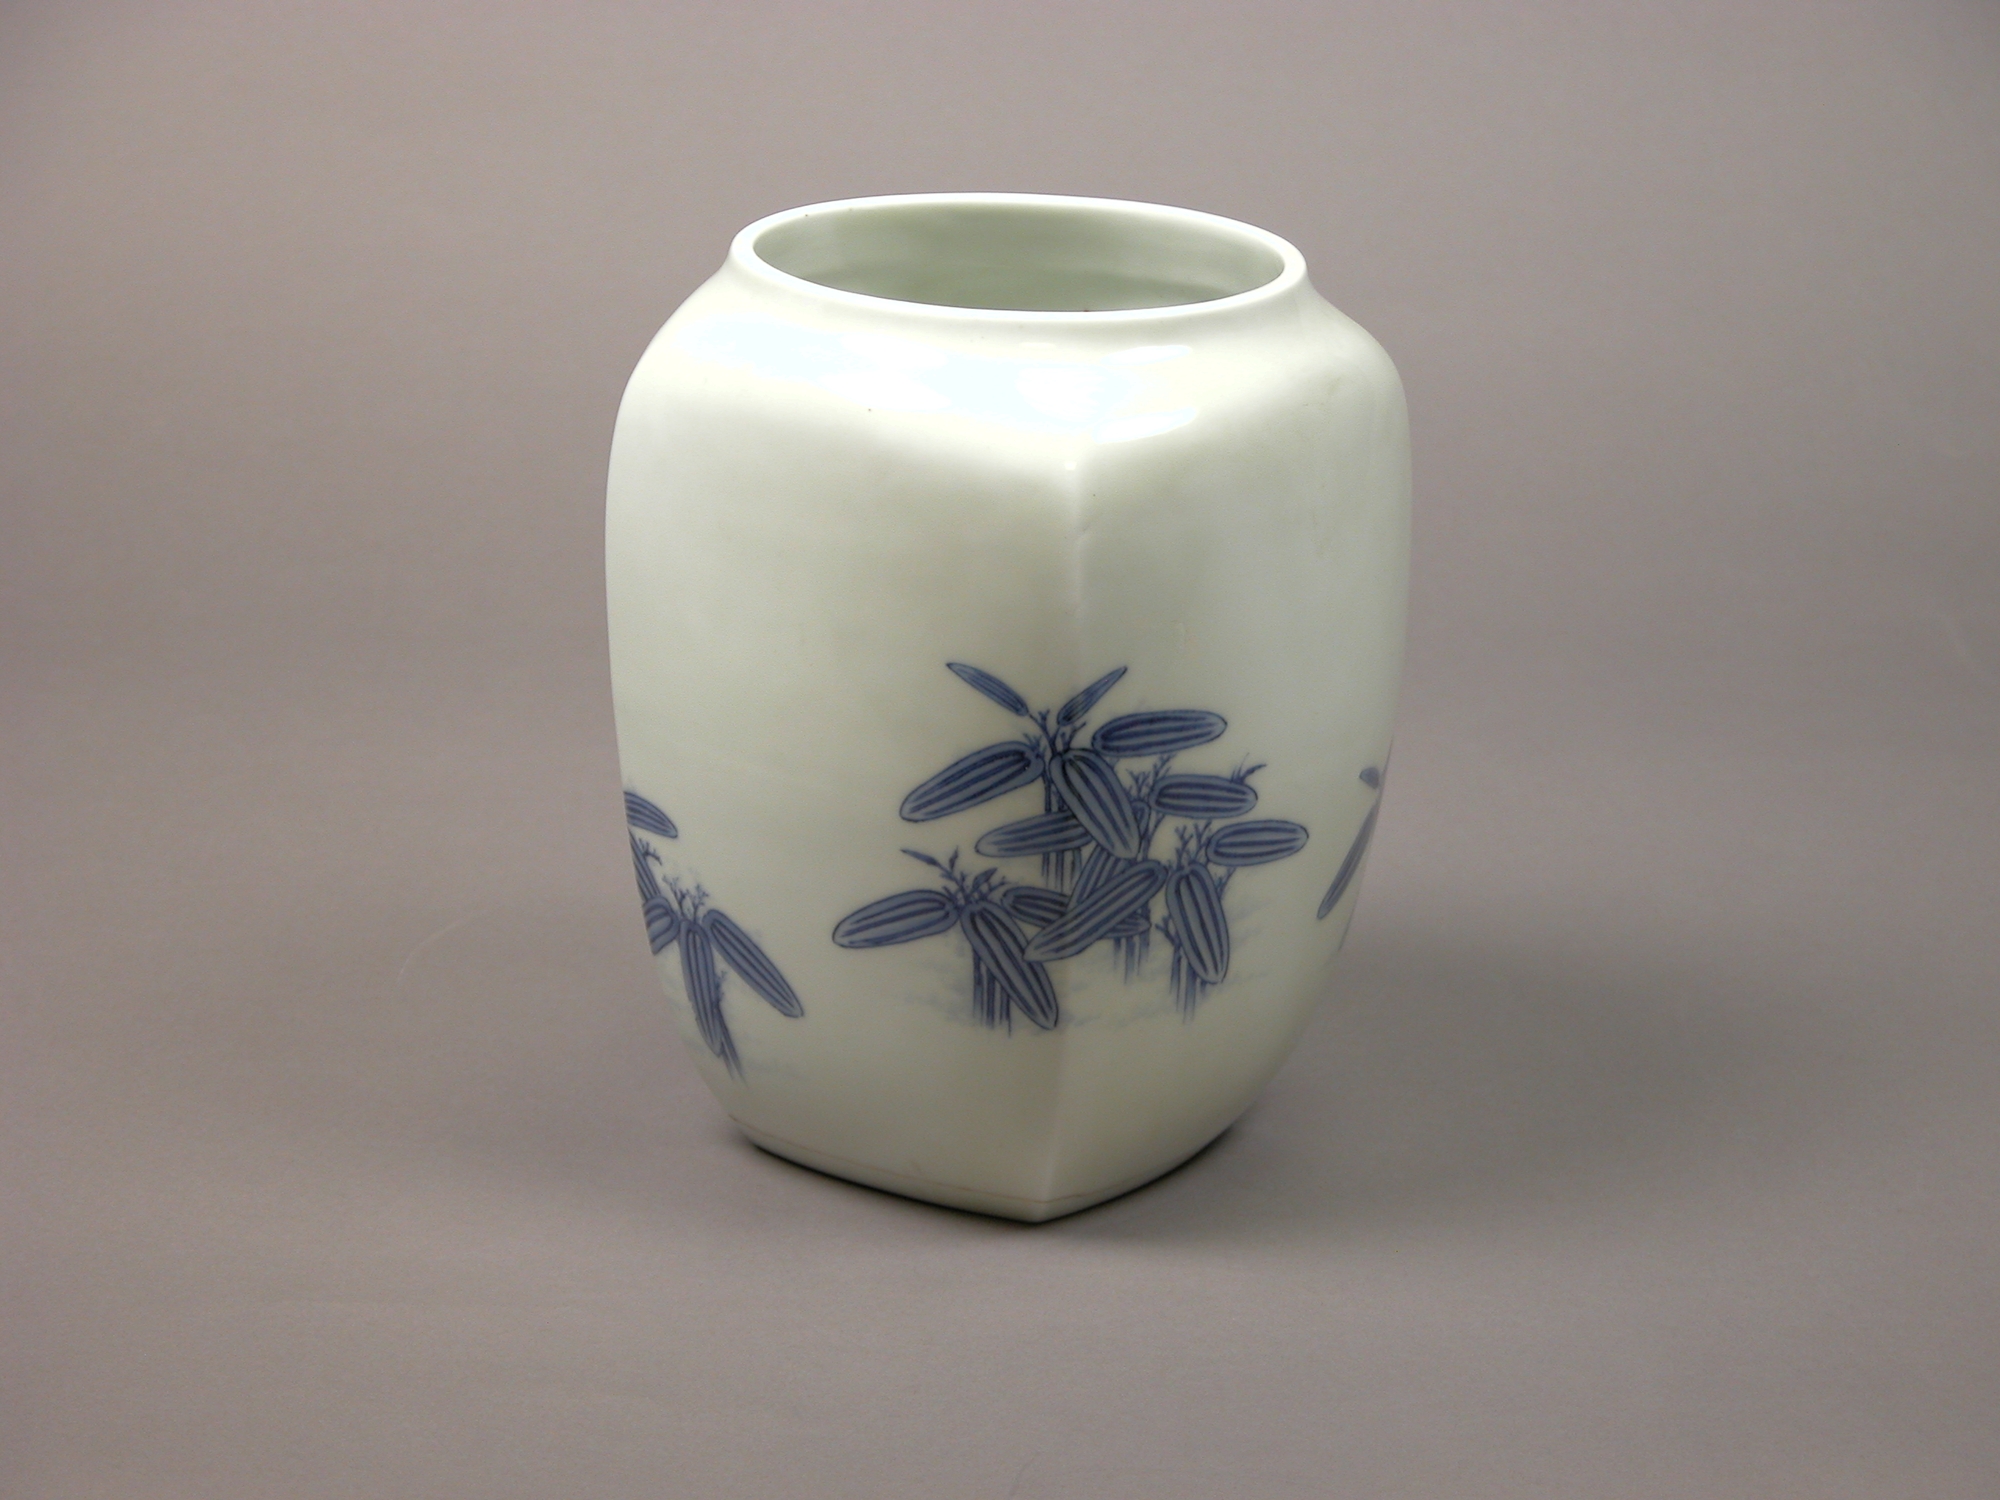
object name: jar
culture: japanese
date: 1780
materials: glaze, porcelain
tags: leaves